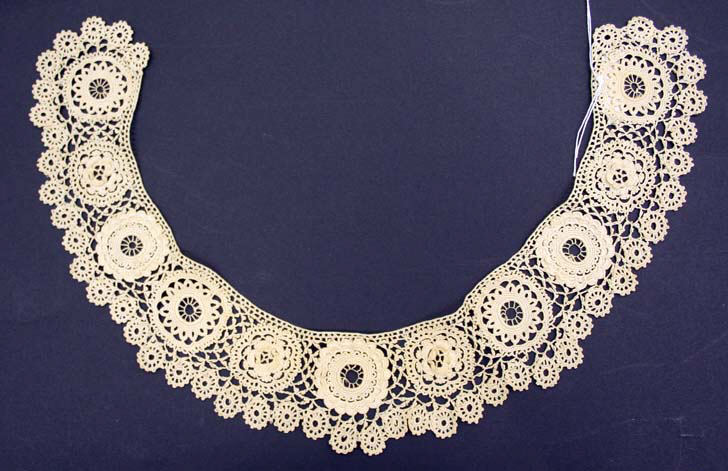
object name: collar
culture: irish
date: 1801-1900